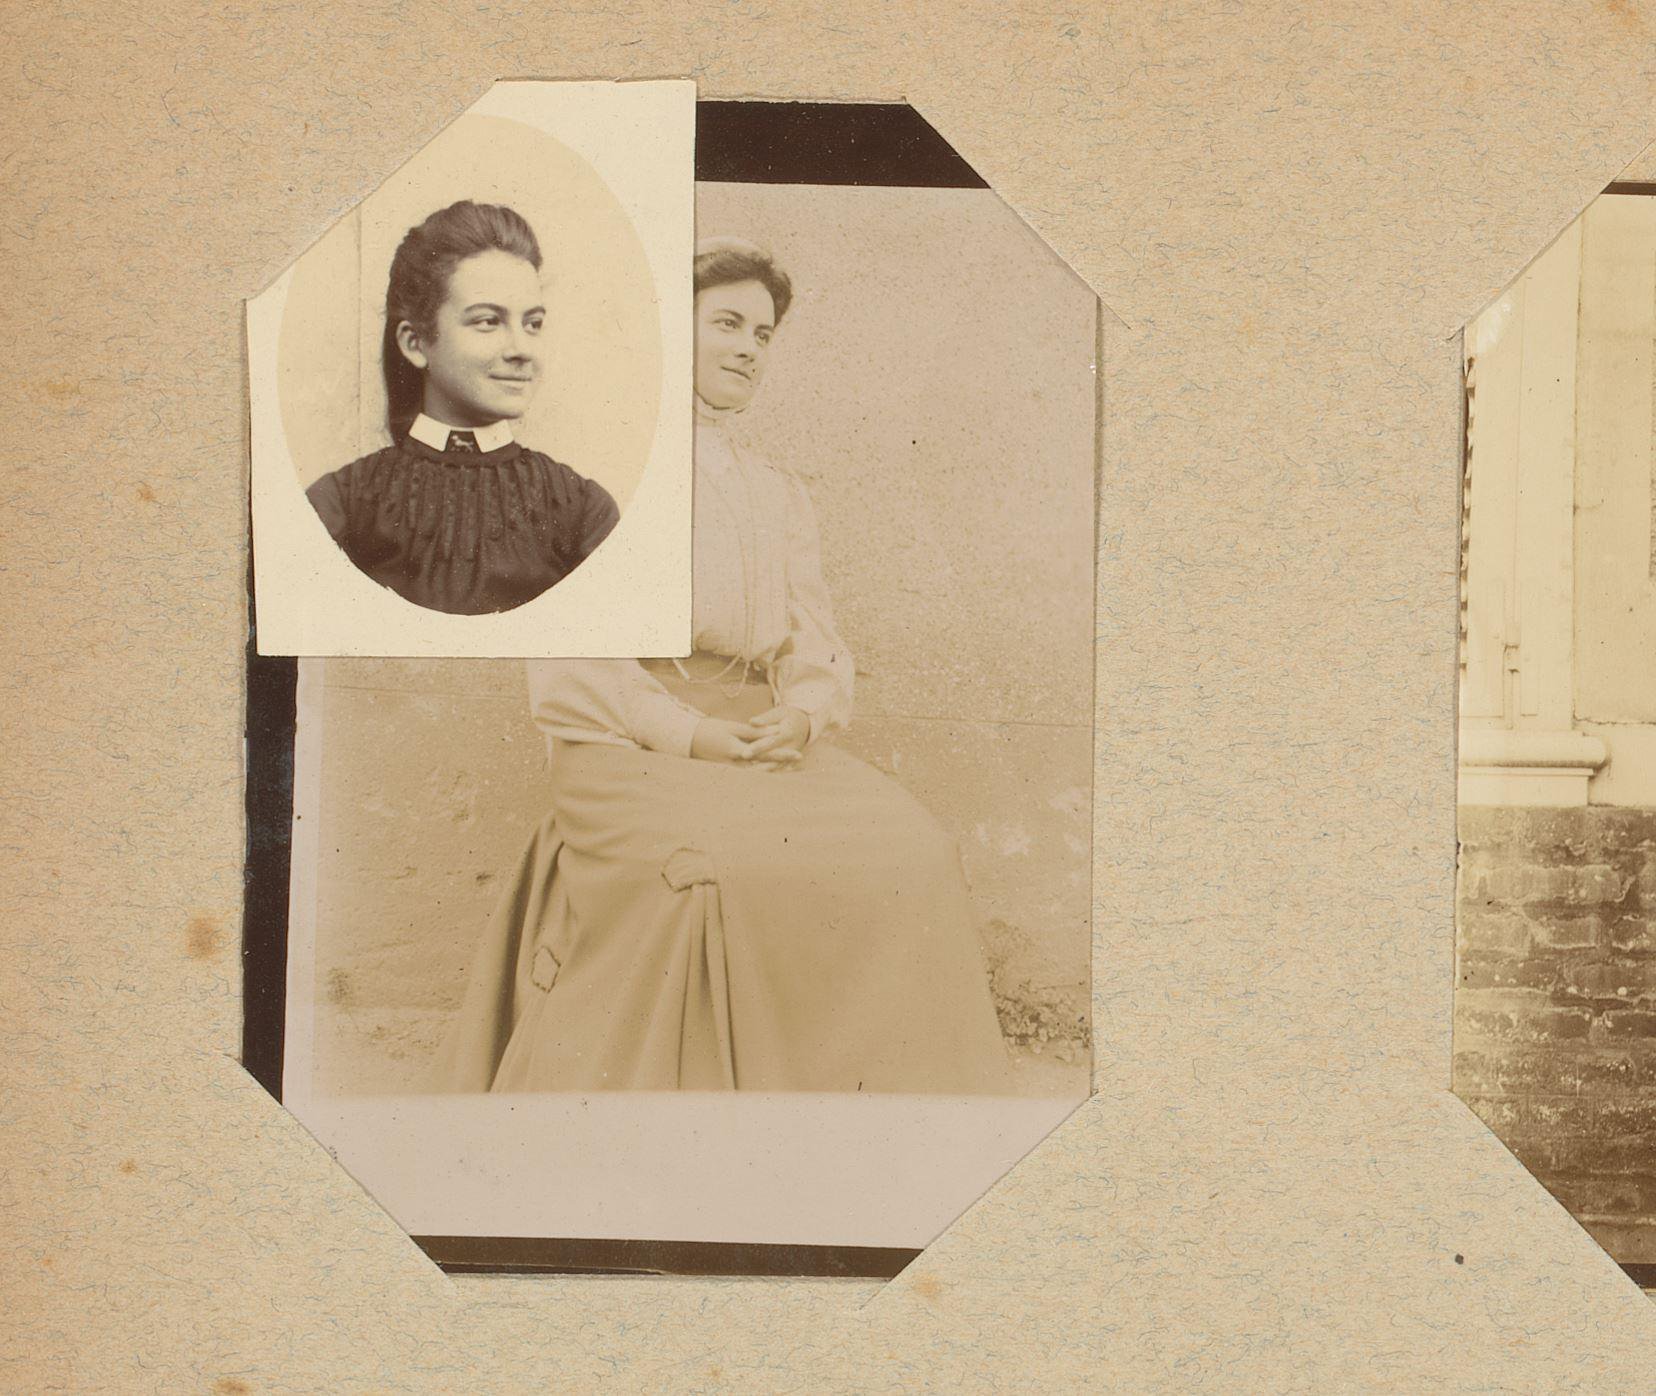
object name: photograph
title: Portret van een zittende vrouw met sluier, mogelijk een bruidssluier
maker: Anonymous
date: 1897-1900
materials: paper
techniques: gelatin silver print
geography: france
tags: adult woman, historical persons, bride (in wedding-dress), france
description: Over de foto is een ander negatief afgedrukt van een voorstelling van bomen.